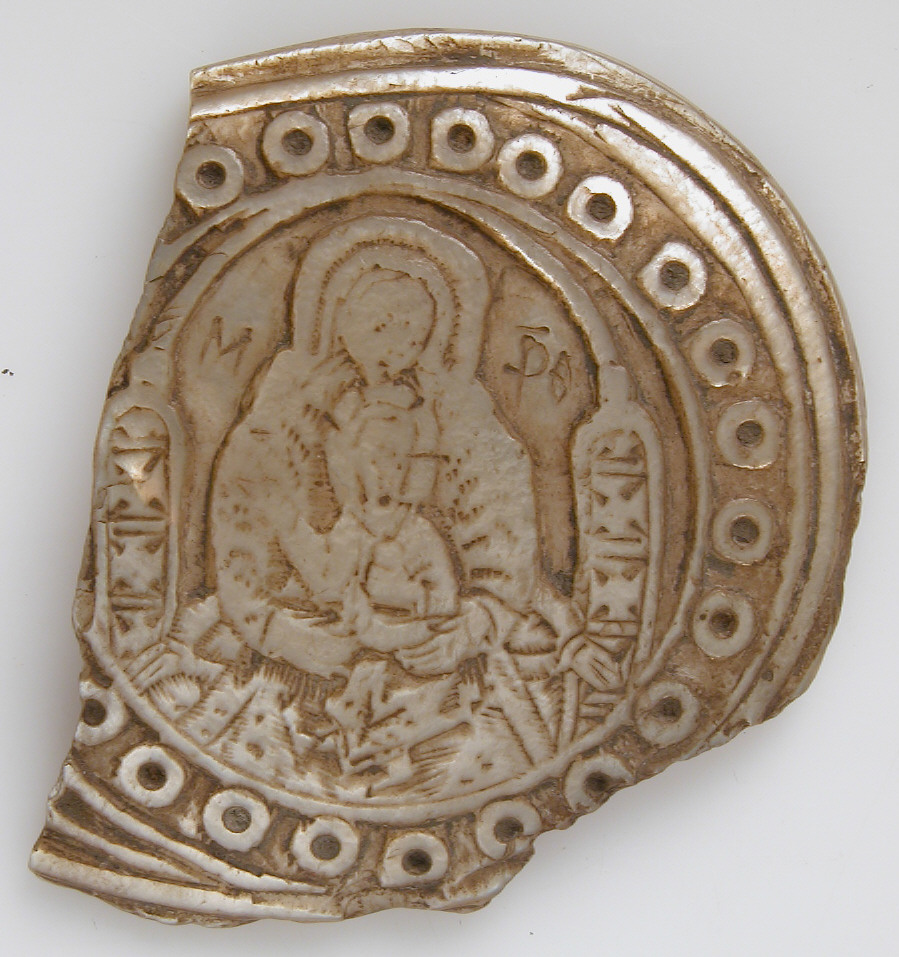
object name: shell fragment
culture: german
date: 1501-1600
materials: mother of pearl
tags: infants,women